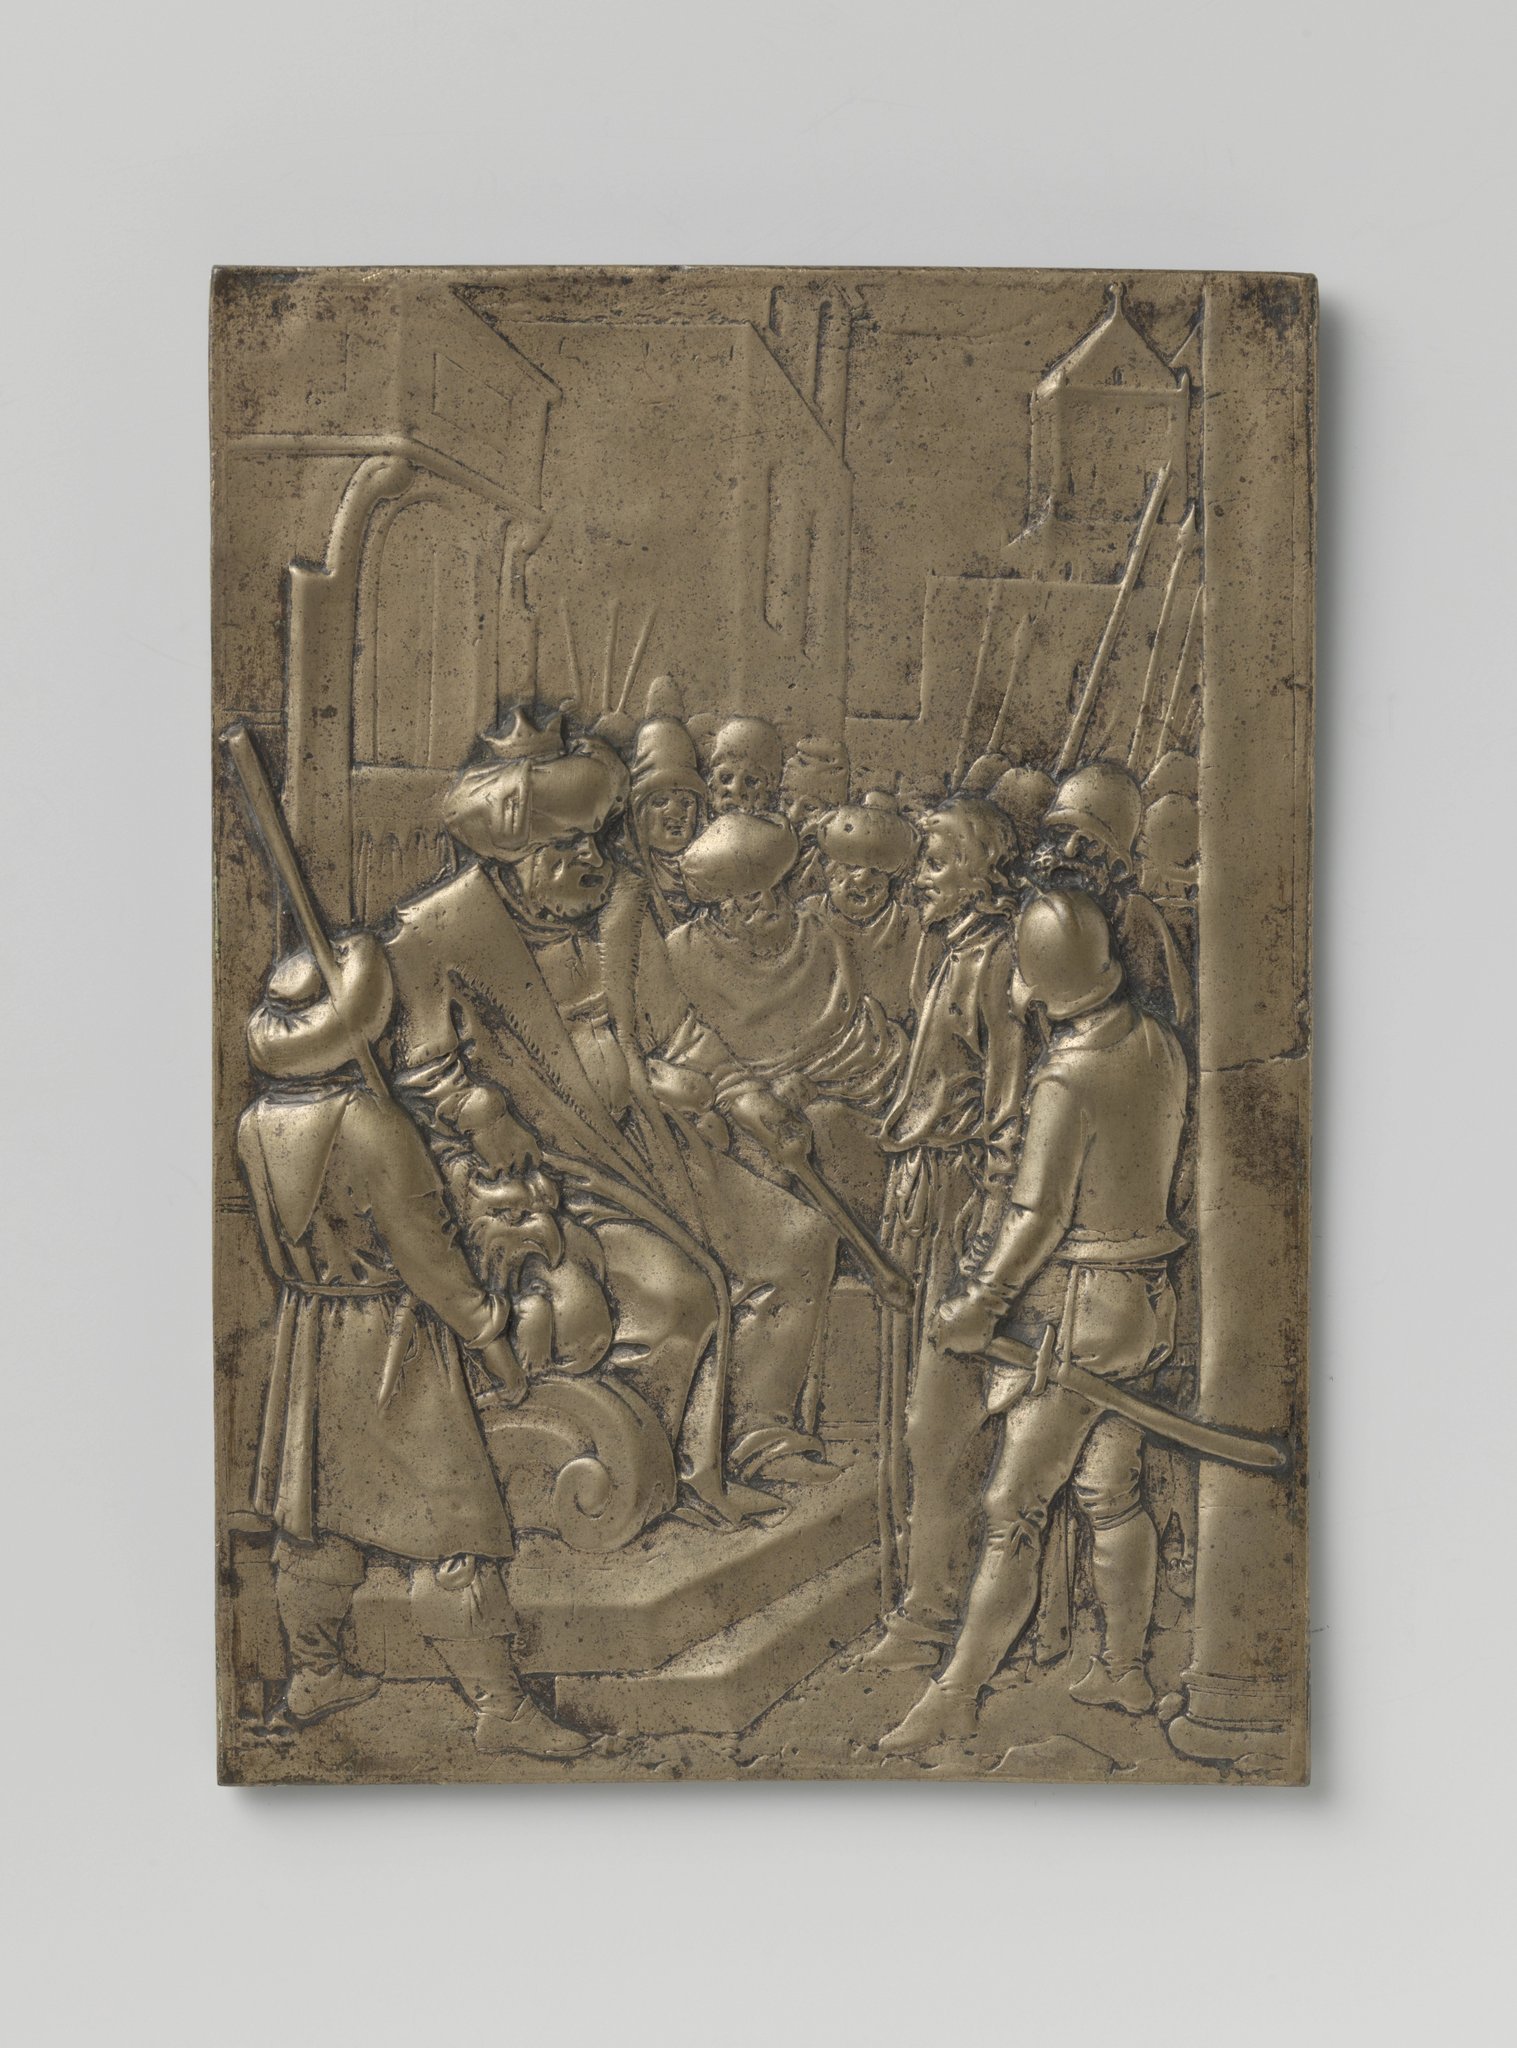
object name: plaque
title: Het lijden van Christus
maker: arent van bolten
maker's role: draughtsman, print maker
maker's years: 1573-1633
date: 1600-1625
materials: bronze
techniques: gilding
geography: northern netherlands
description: Rechthoekige, verguld bronzen plaquette met Jezus voor Pilatus.